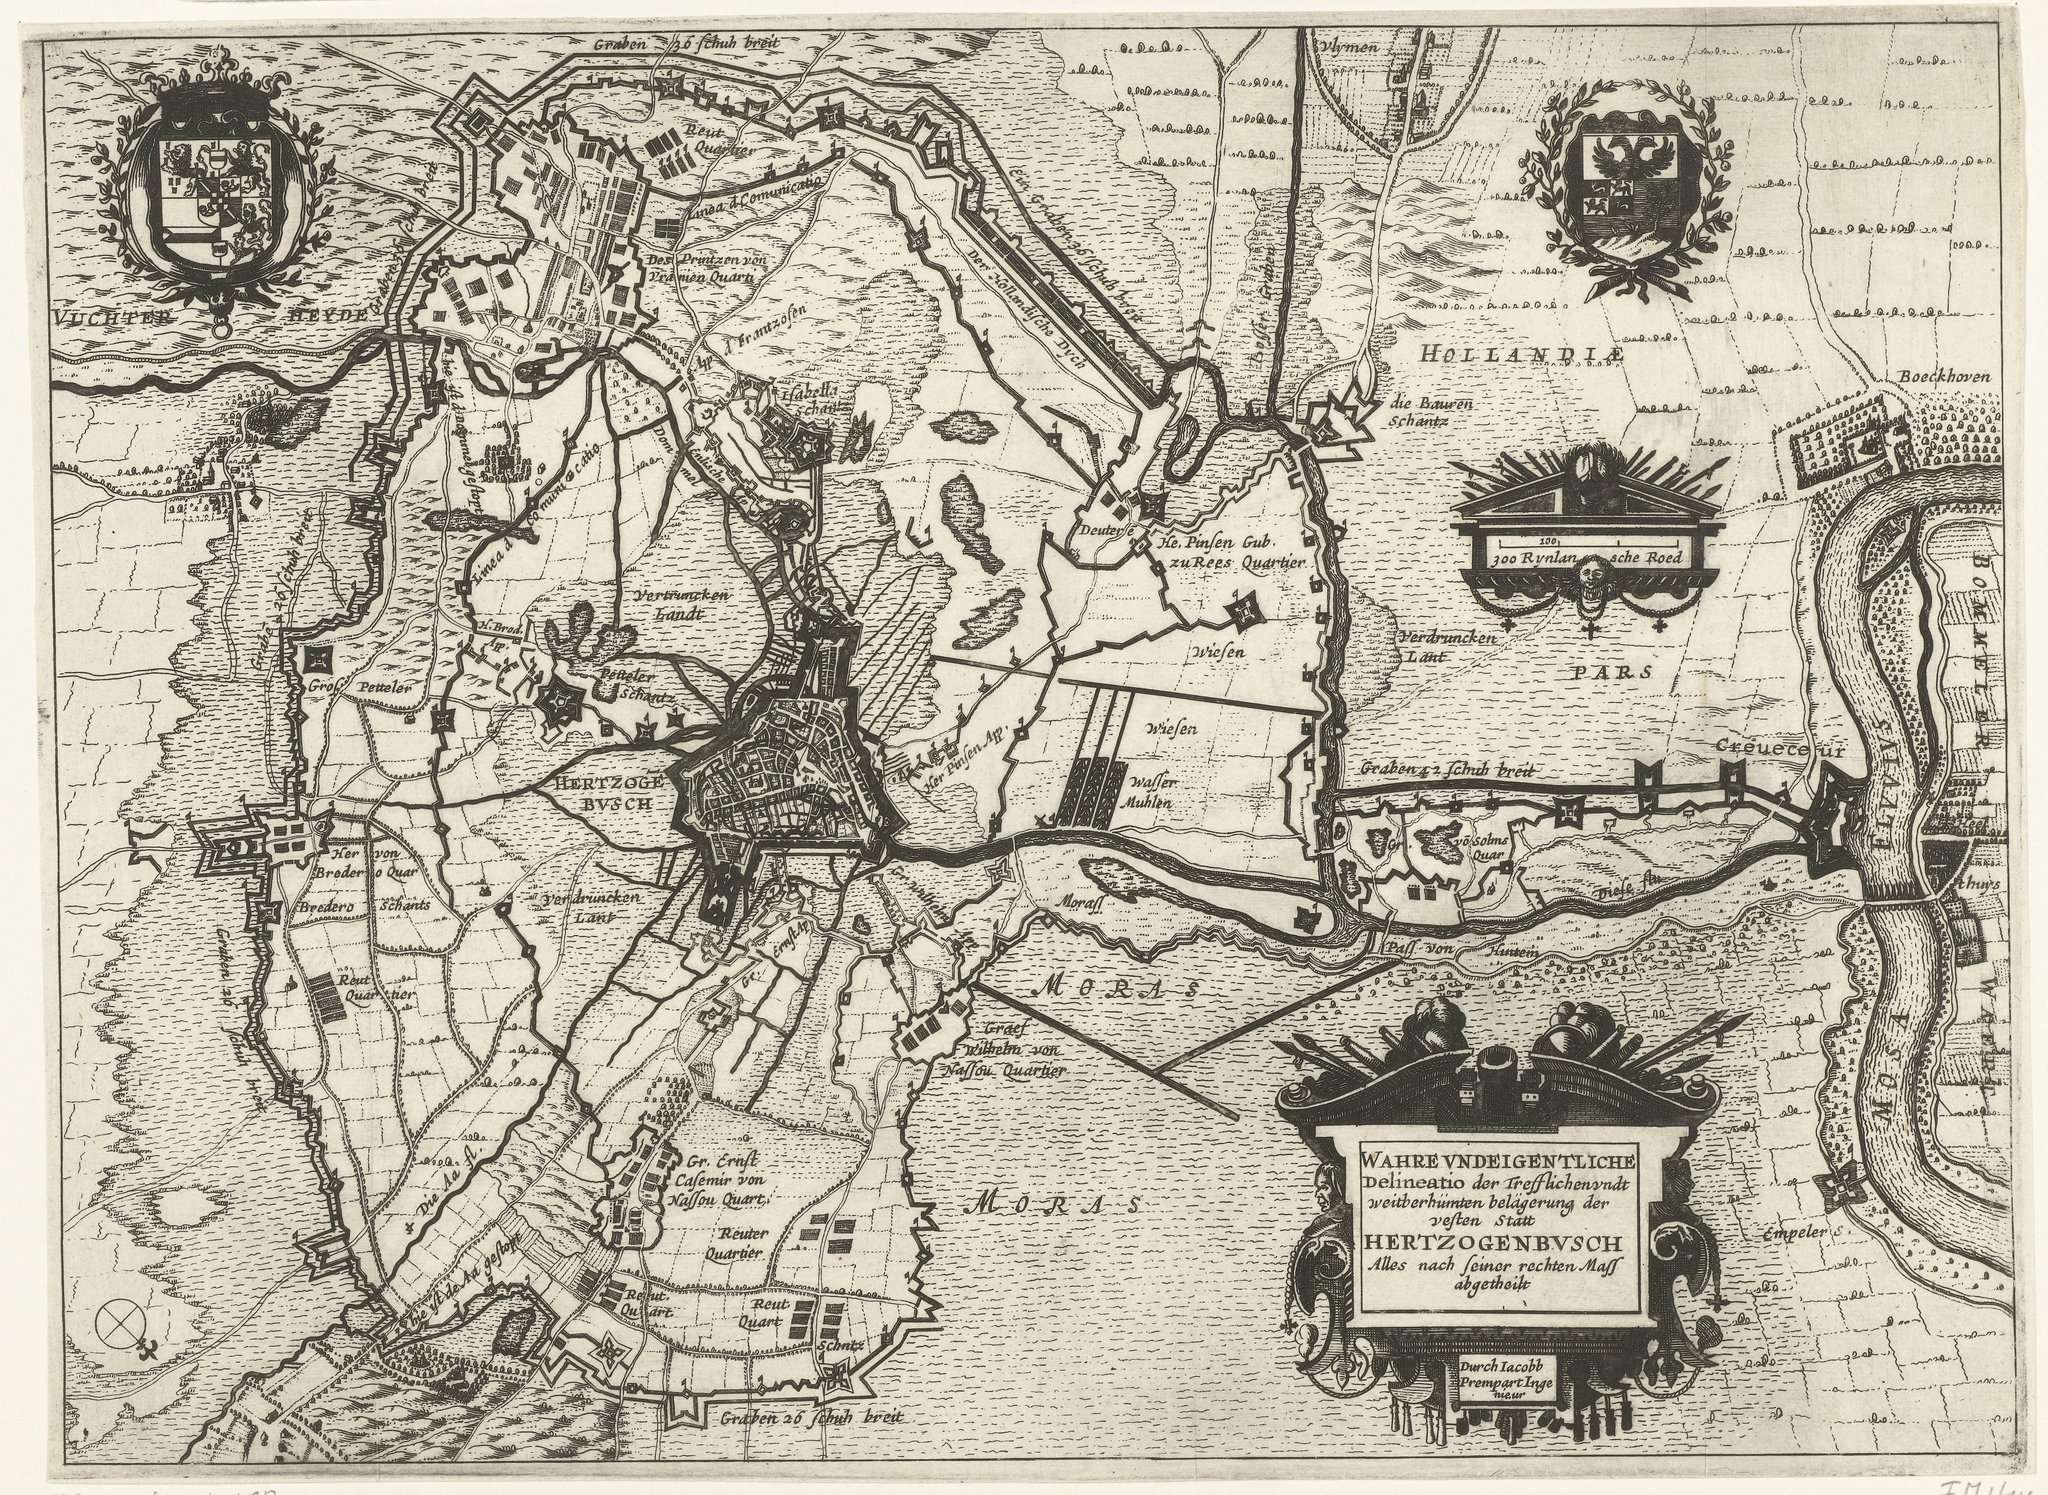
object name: print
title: Wahre und eigentliche Delineatio der Trefflichen undt weitberhümten belägerung der vesten Statt Hertzogenbusch Alles nach seiner rechten Mass abgetheilt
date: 1629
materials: paper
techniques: etching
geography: germany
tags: the hague, frederick henry (prince of orange), maps of separate countries or regions, siege, position war, den bosch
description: Kaart van het beleg van Den Bosch door het Staatse leger onder Frederik Hendrik, van 1 mei tot 17 september 1629. Kaart van Den Bosch en het omliggende gebied met de omsingeling van de stad, rechts Crèvecoeur aan de Maas. Rechtsonder een cartouche met de Duitse titel. Bovenaan links het wapen van Frederik Hendrik, rechts het wapen van de stad.